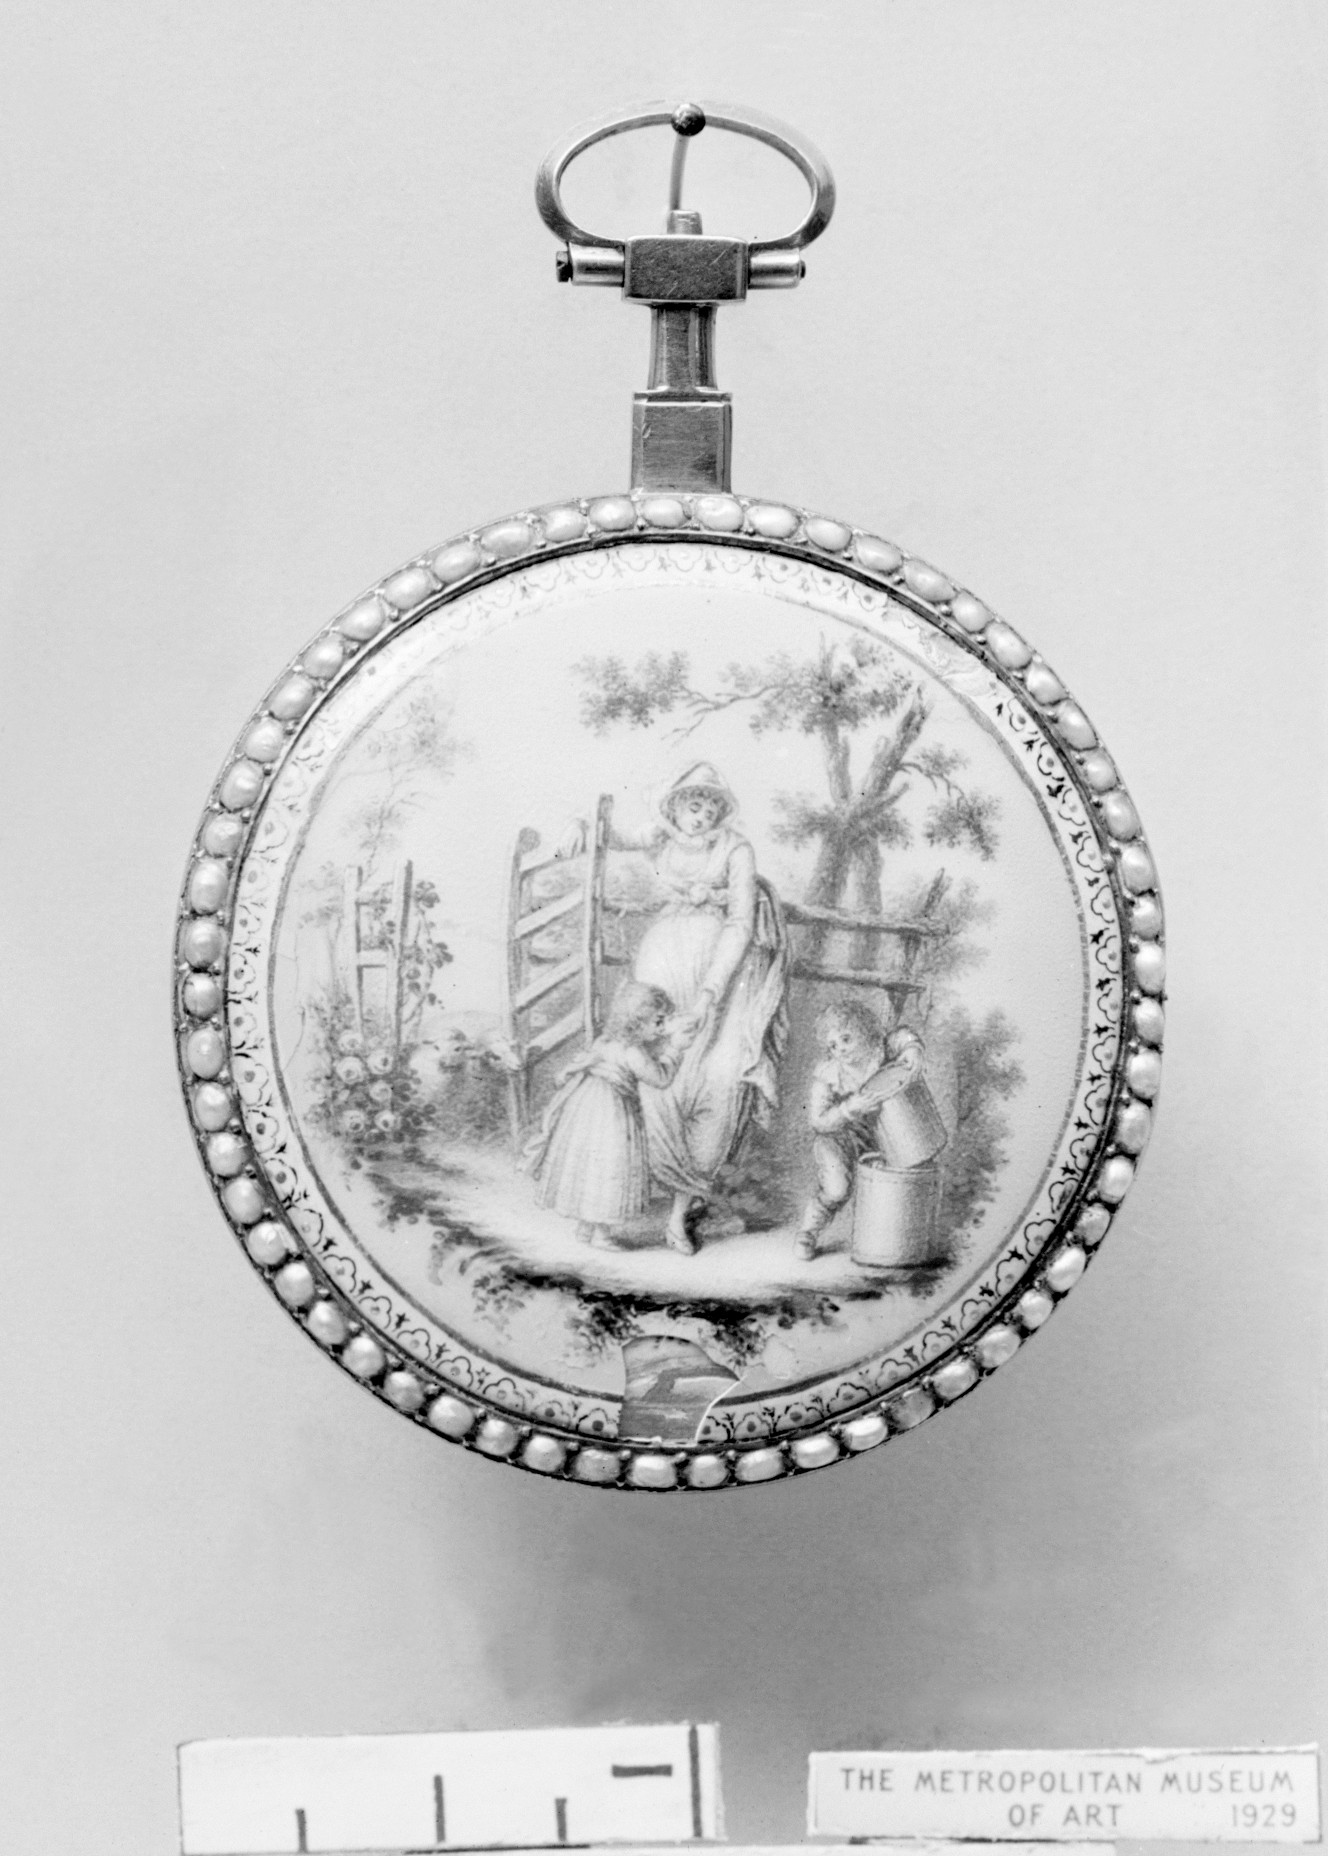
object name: watch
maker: pierre gregson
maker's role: maker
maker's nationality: british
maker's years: 1778-1795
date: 1785-1790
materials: enamel, gold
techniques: painting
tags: boys,girls,women,trees